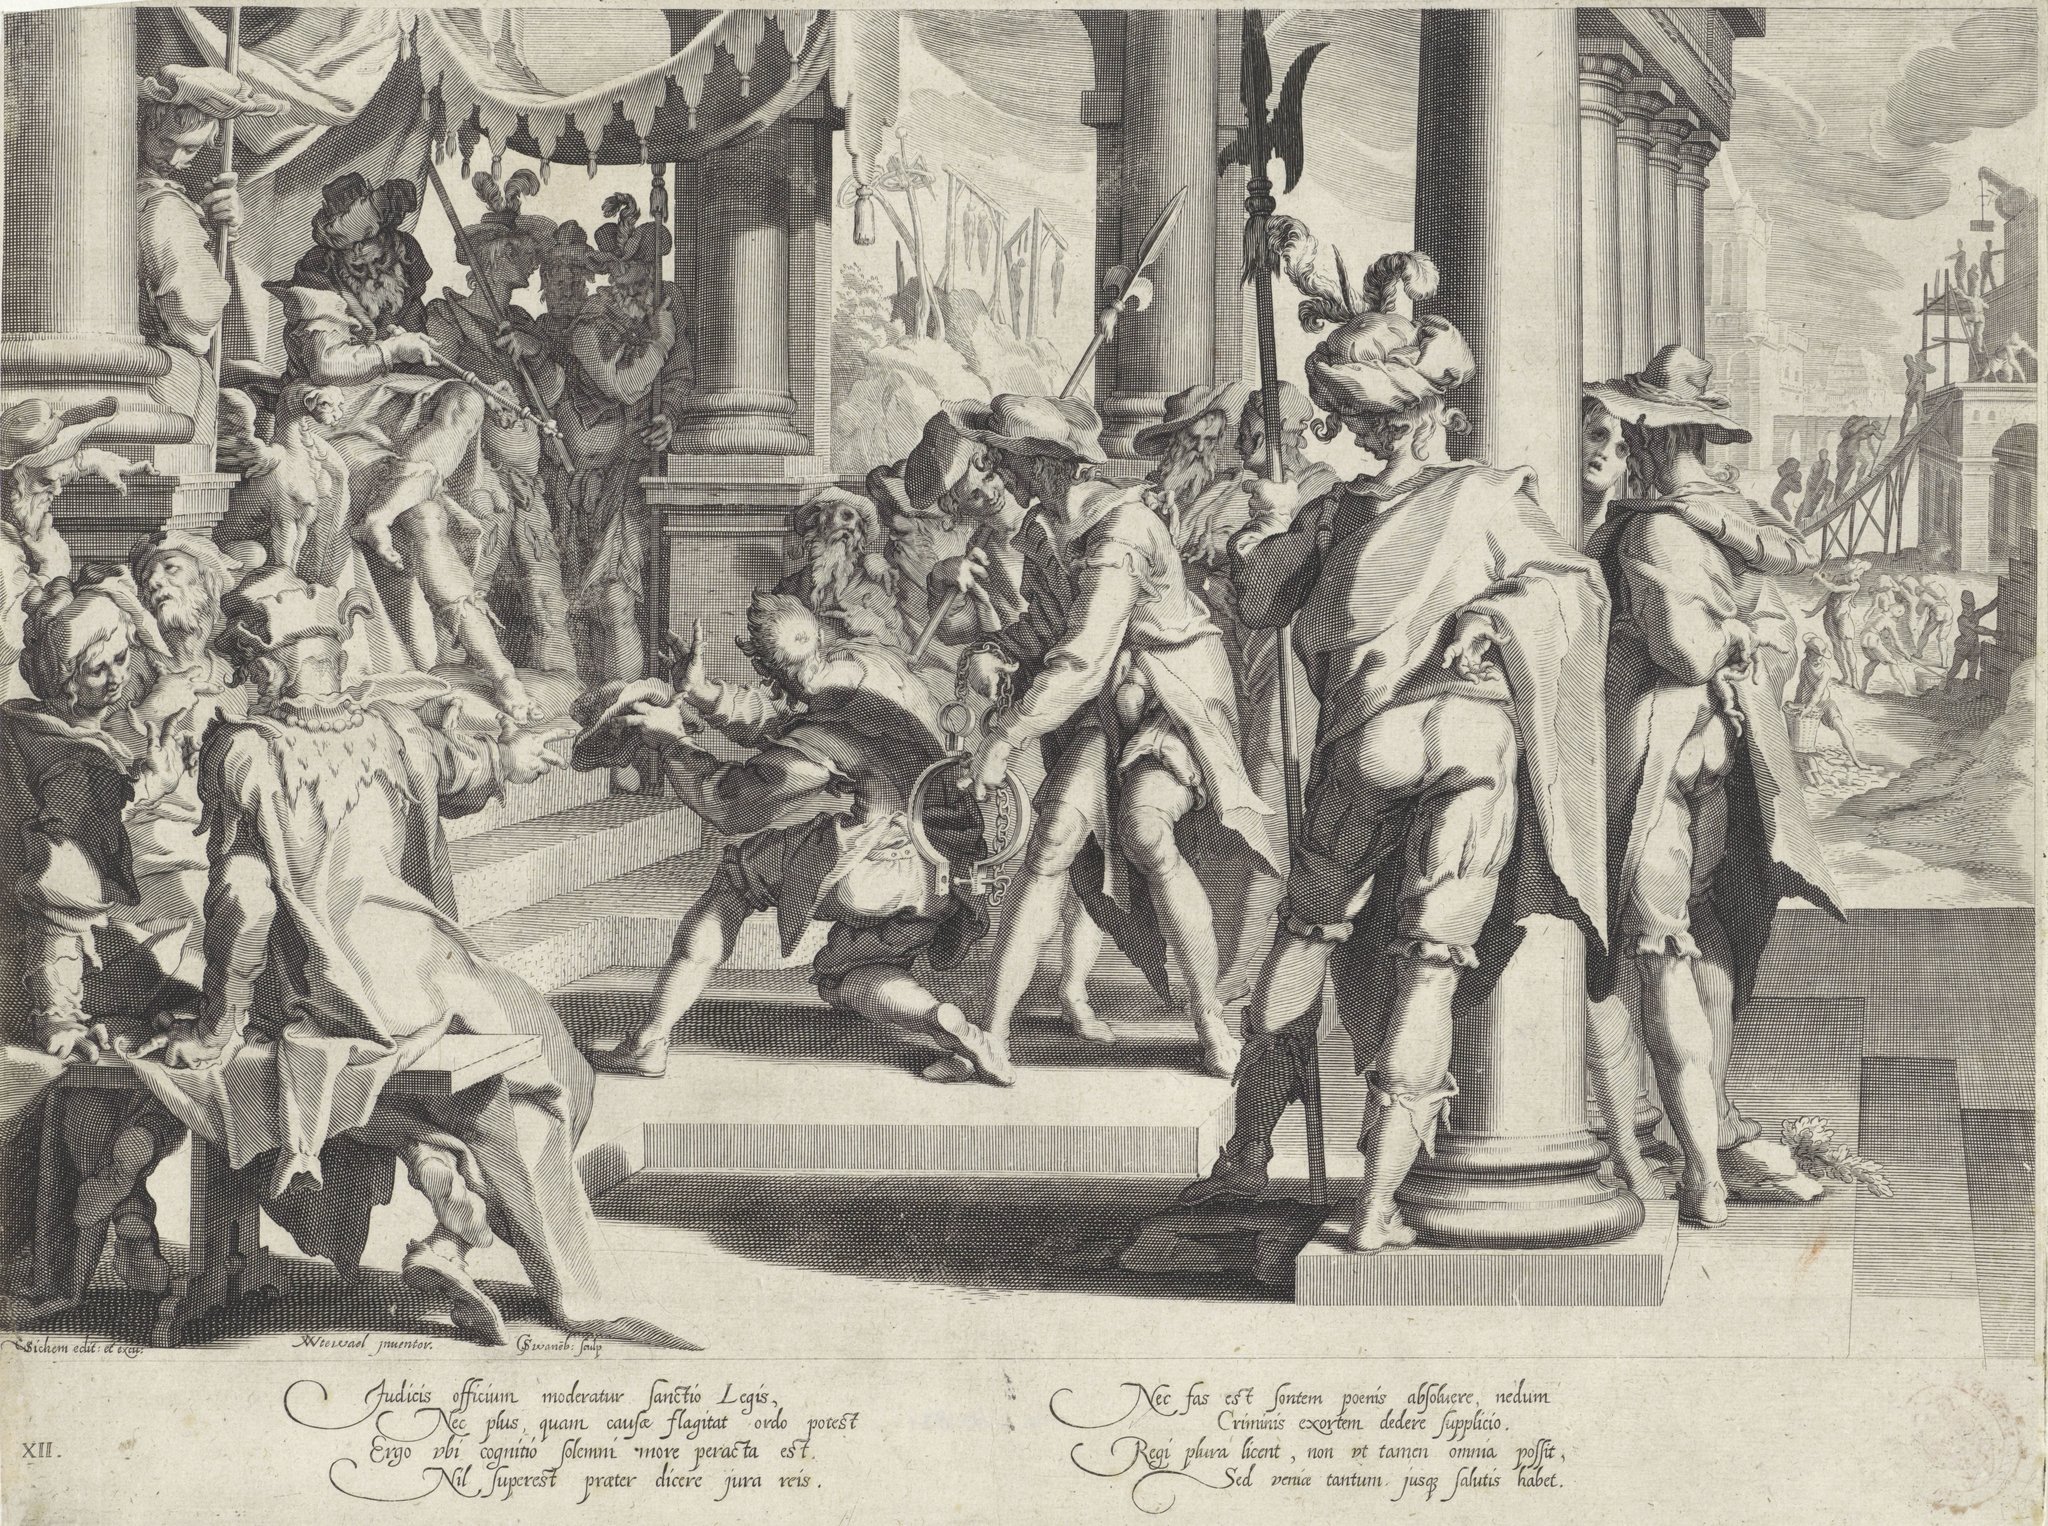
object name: print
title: Thronus Justitiae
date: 1606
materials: paper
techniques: engraving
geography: leiden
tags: granting mercy; free pardon, juridical examples; exemplary judges; 'gerechtigkeitsbilder'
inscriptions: collector's mark: Lugt 240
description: Een koning zit op zijn troon en spreekt recht. Hij wijst met zijn staf naar de aangeklaagde ten teken dat hij de man vergeving verleent. Op de achtergrond een galgenveld en een gebouw in aanbouw. Onder de voorstelling twee vierregelige verzen in het Latijn over de onschendbaarheid van het recht. Een koning moet zich ook aan de wet houden, maar de koning heeft de autoriteit om te vergeven.